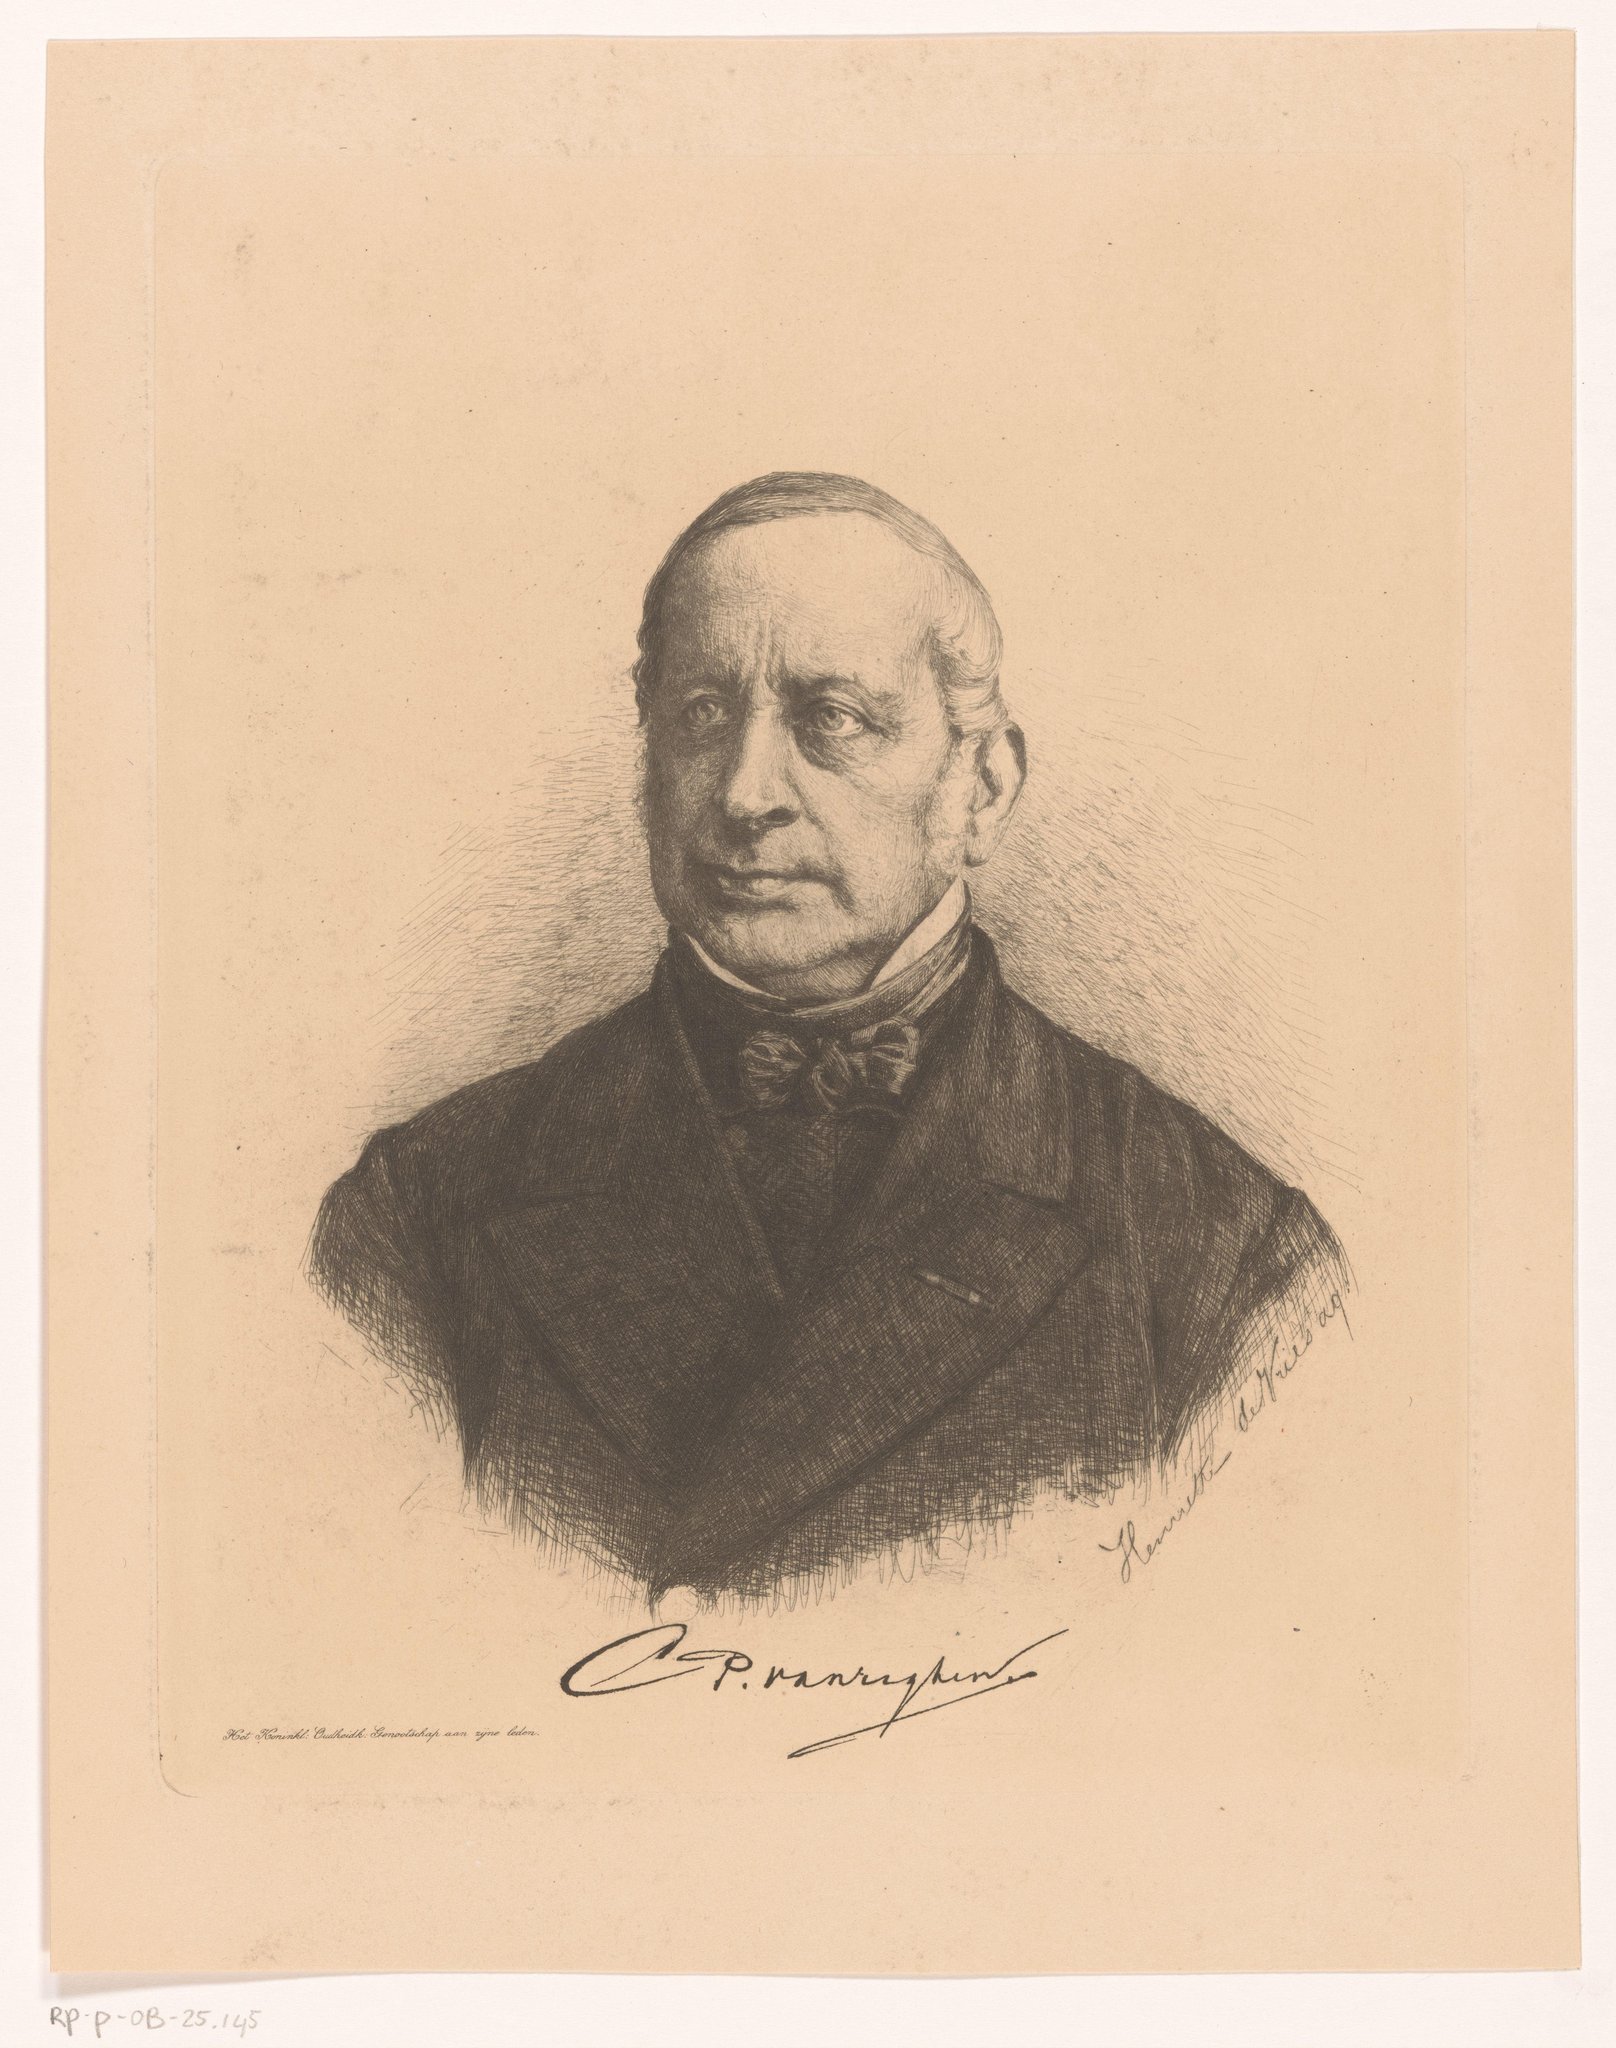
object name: print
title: Portret van Christiaan Pieter van Eeghen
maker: henriëtte de vries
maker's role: draughtsman, print maker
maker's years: 1867-1942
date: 1877-1942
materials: paper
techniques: etching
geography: netherlands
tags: historical persons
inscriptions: collector's mark: Lugt 2228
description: Onder het portret staat gedrukt: 'Het Koninkl: Oudheidk. Genootschap aan zijne leden.